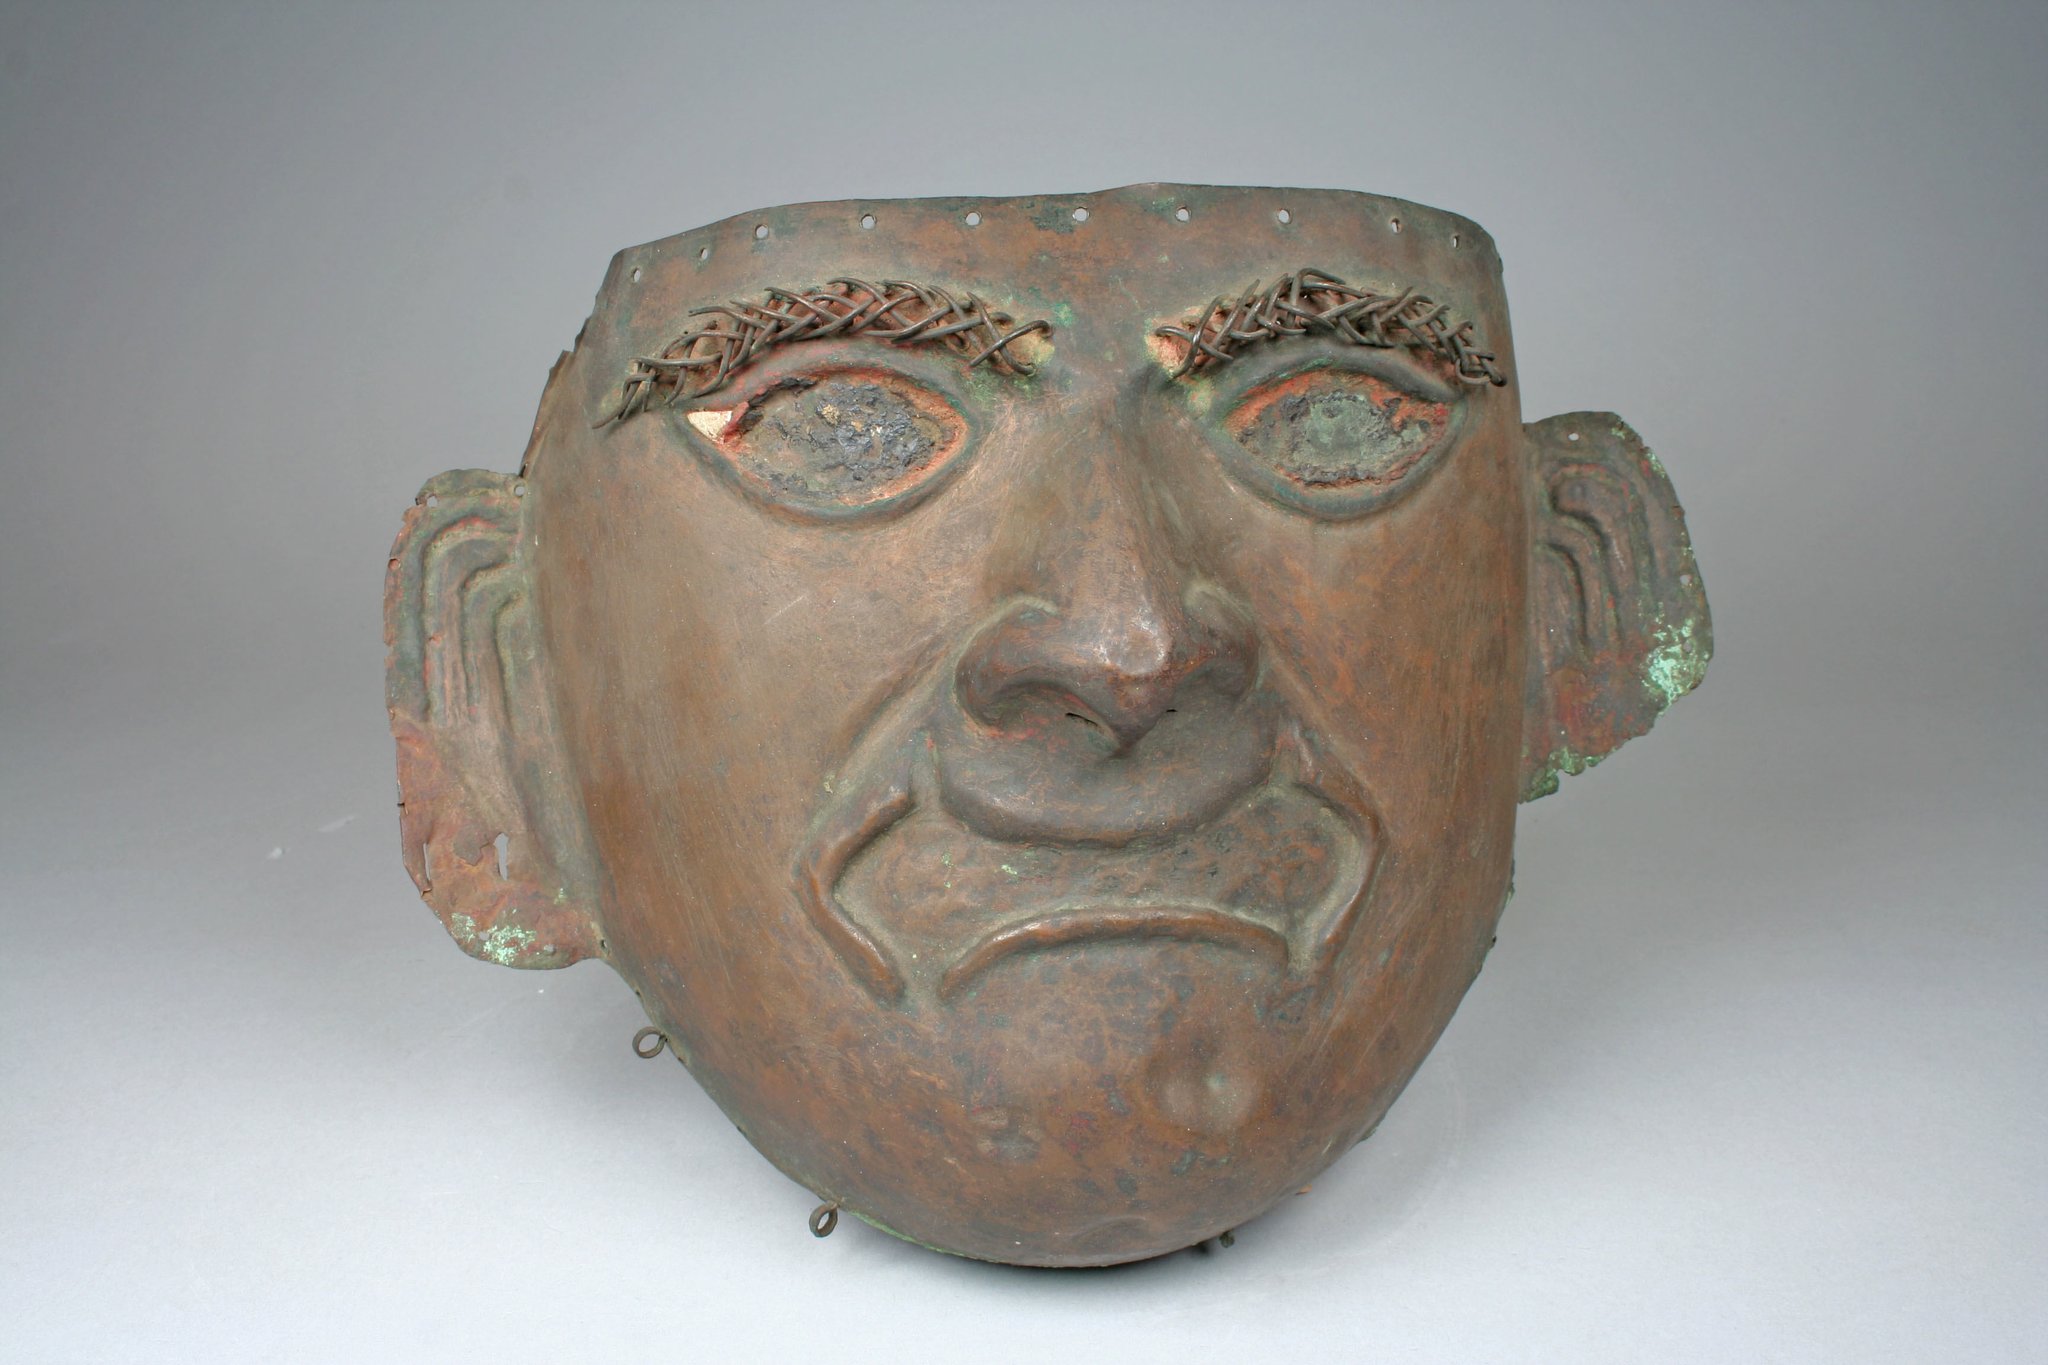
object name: mask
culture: moche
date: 301-700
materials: copper, pigment, shell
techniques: inlay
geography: peru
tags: faces